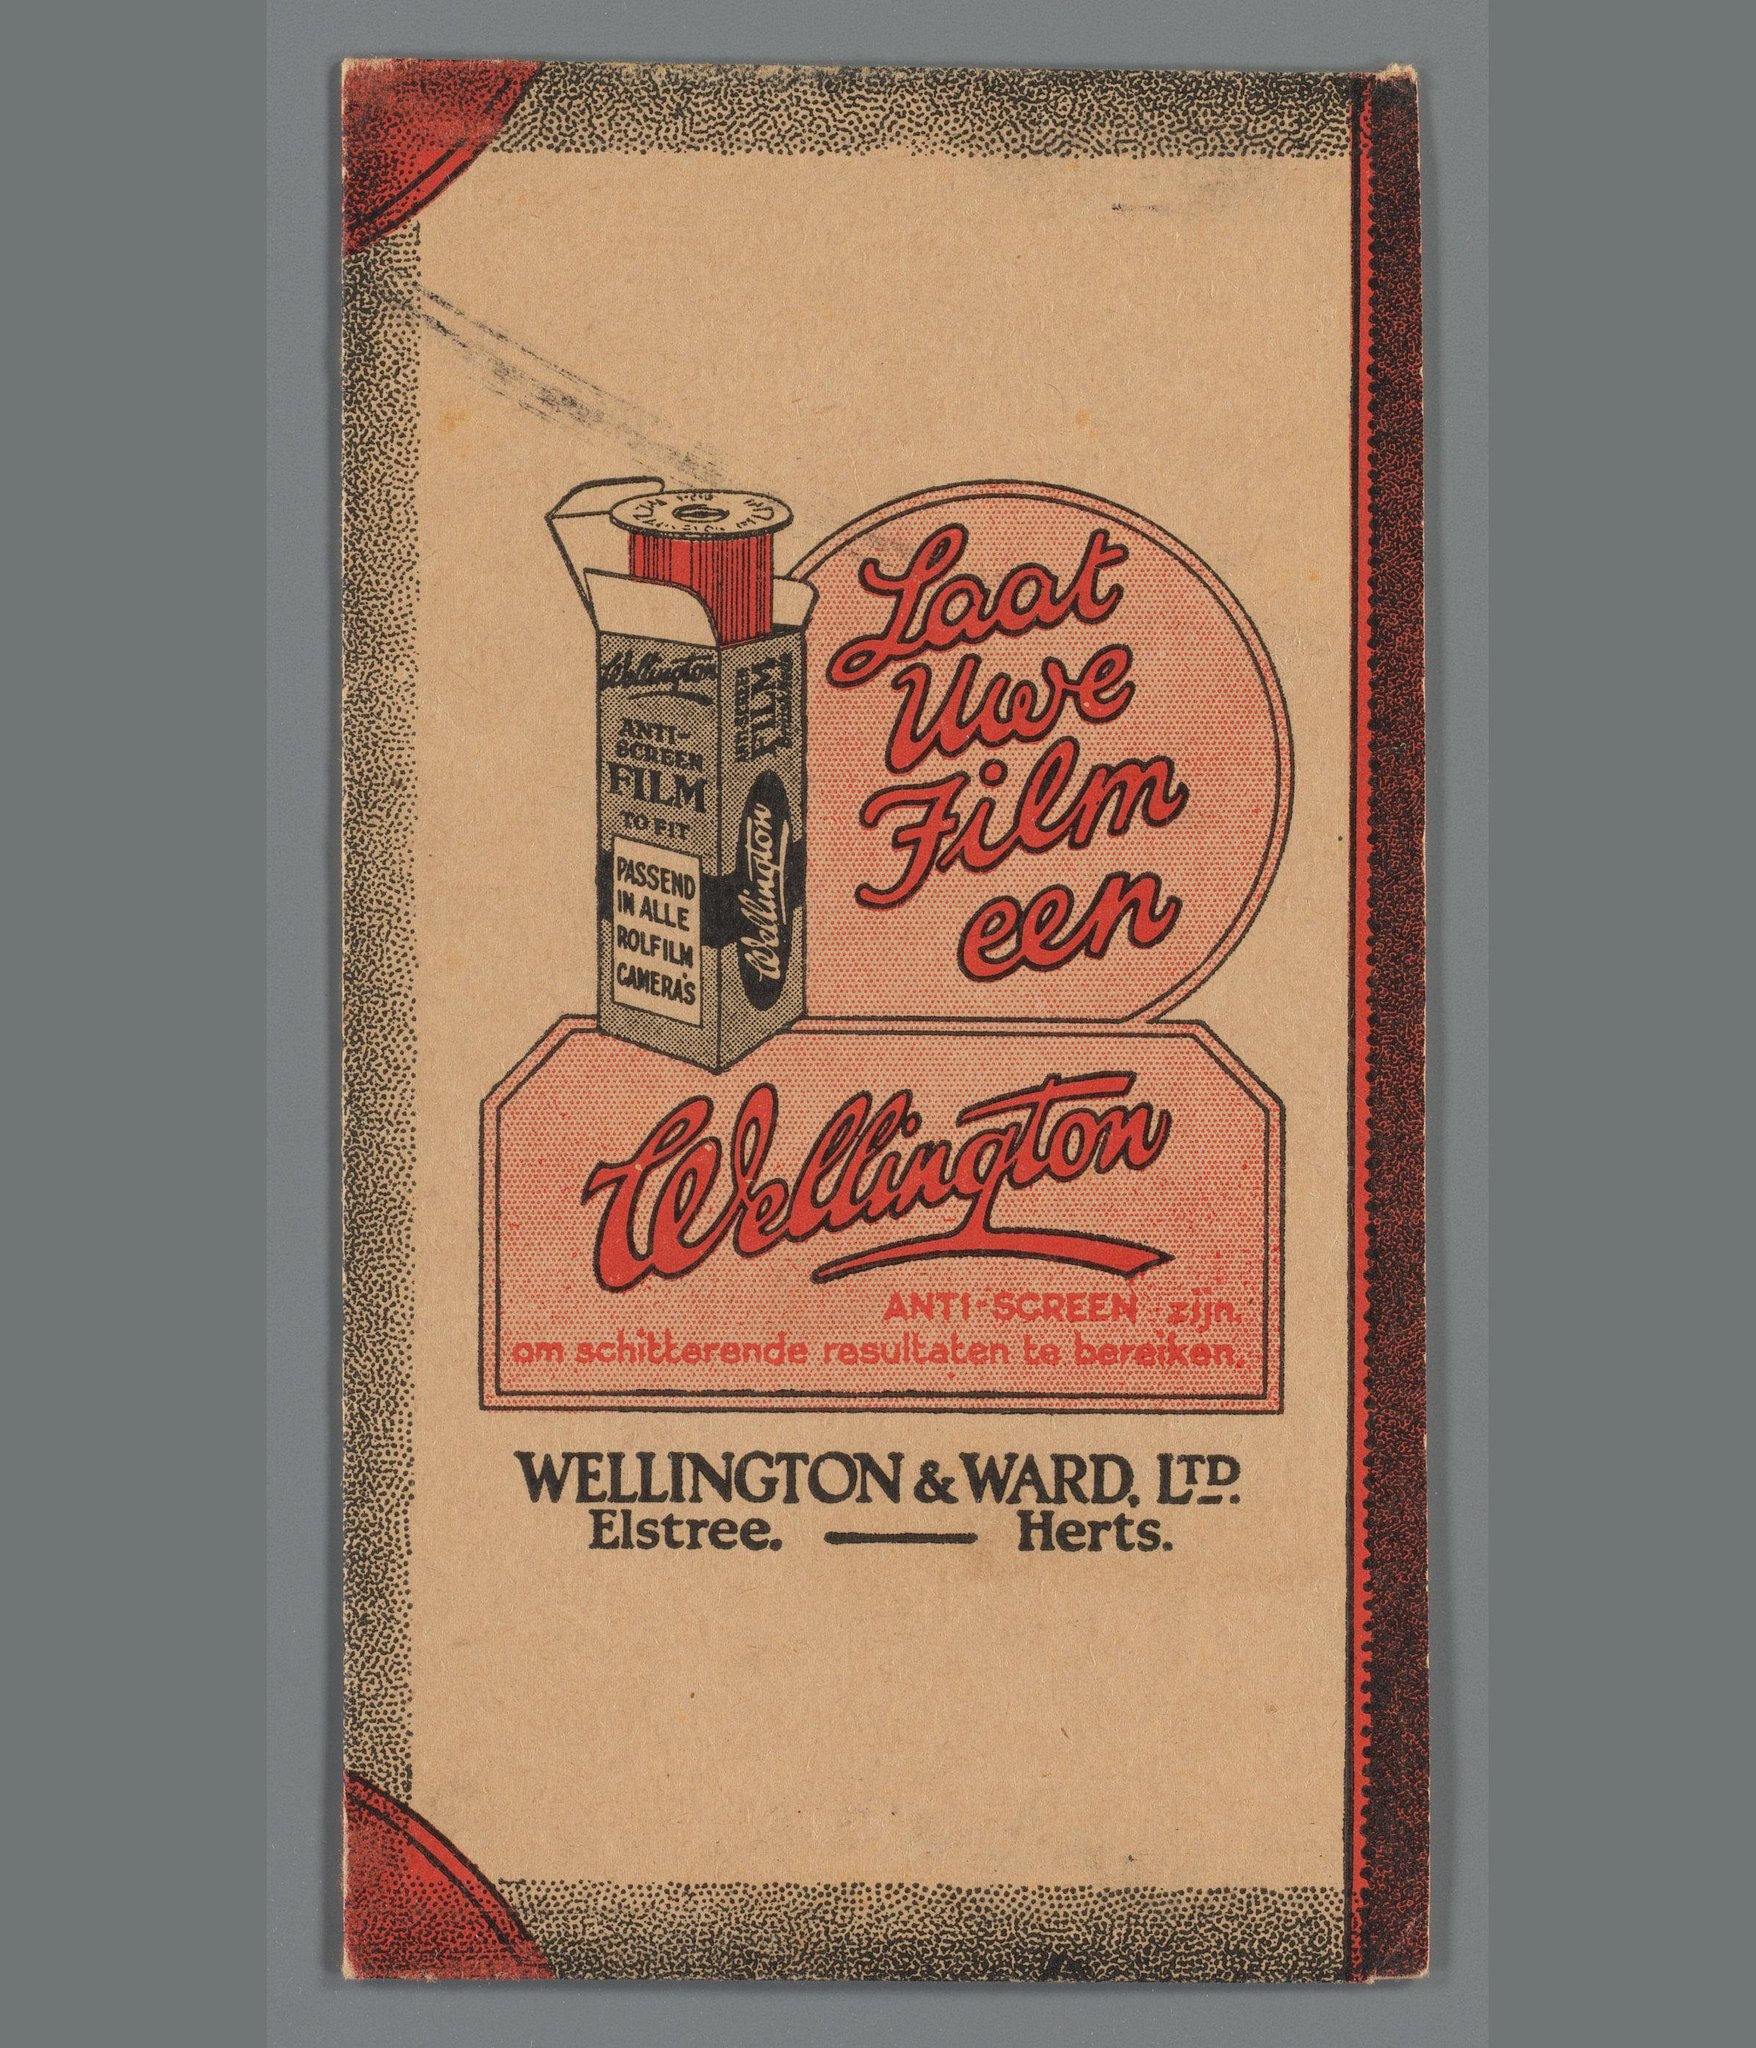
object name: print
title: Verpakking voor fotoafdrukken van Wellington & Ward Ltd.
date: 1930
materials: cardboard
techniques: letterpress printing, lithograph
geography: hertfordshire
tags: storing, conserving, preserving (of products), printing ~ film